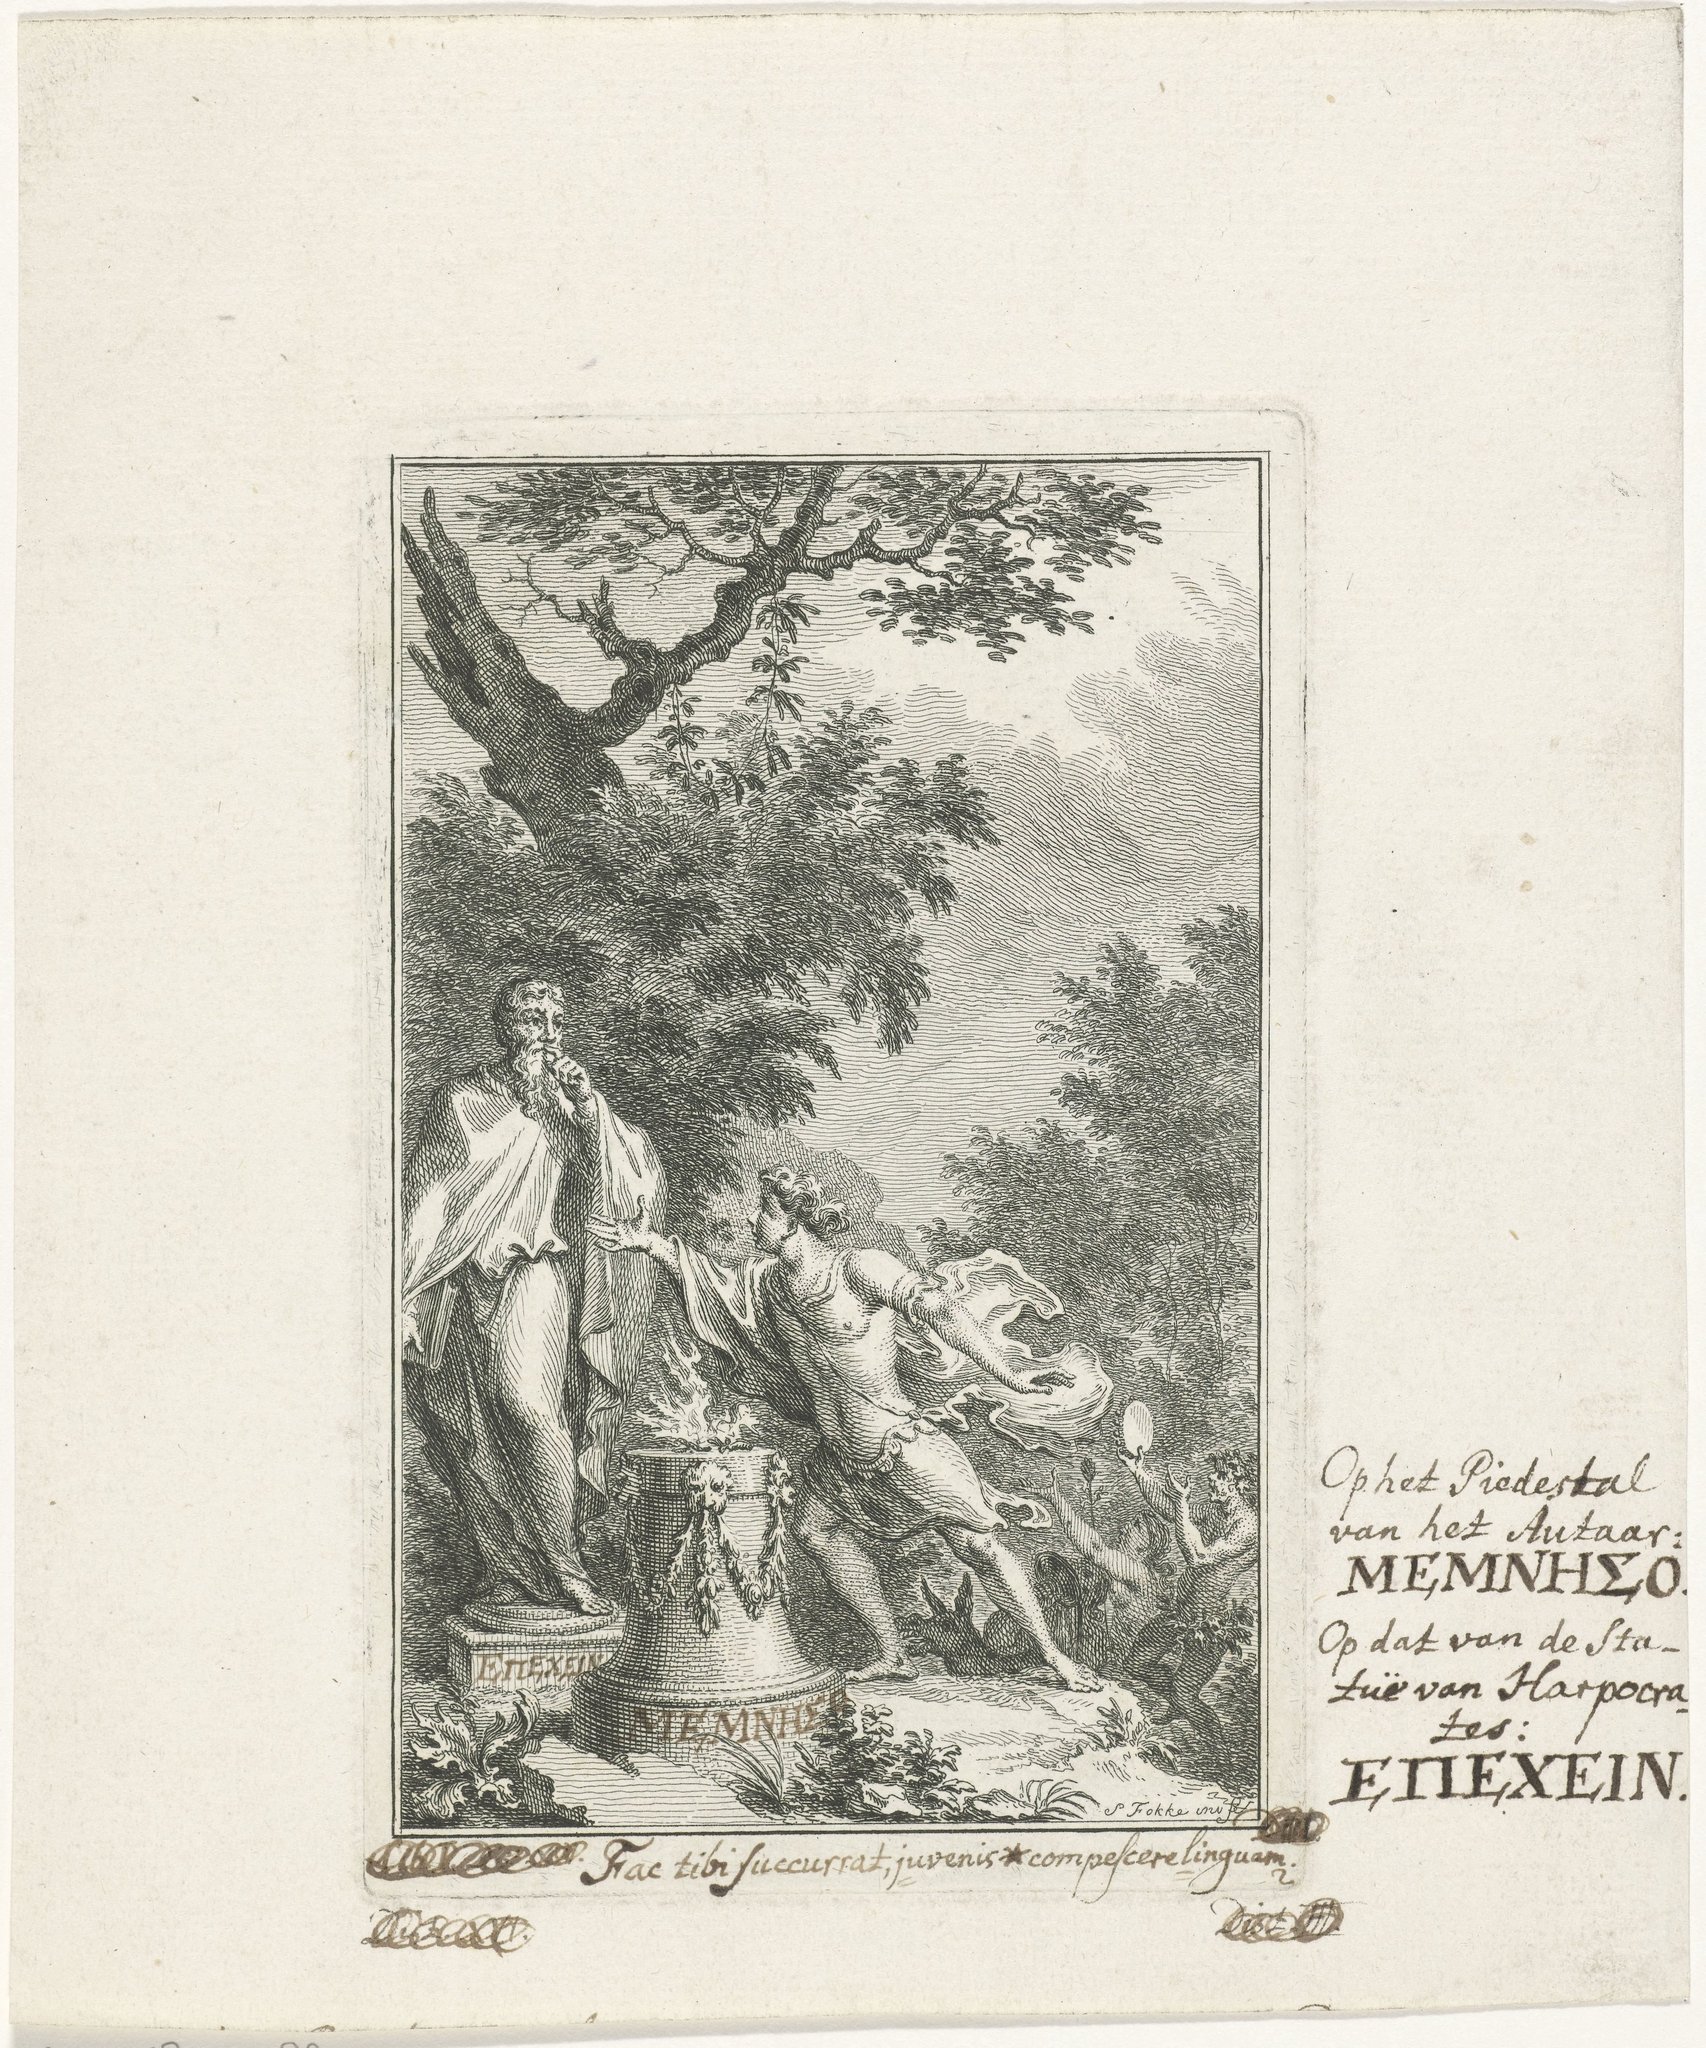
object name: print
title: Jongeman bij een standbeeld van Harpocrates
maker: simon fokke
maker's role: draughtsman, print maker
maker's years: 1712-1784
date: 1759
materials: paper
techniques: etching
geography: amsterdam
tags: tambourine, harpocrates, statues, paintings, etc. ~ objects of worship (non-christian religions) - bb - in the open air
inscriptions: caption: ‘Fac tibi succurat, juvenis * compescero linguam’, inscription, number: ‘2’, collector's mark: Lugt 240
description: Een jongeman reikt met zijn hand naar het standbeeld van Harpocrates. Voor het beeld staat een brandende offerzuil. Op de achtergrond een ezel en dansende figuren met tamboerijn.